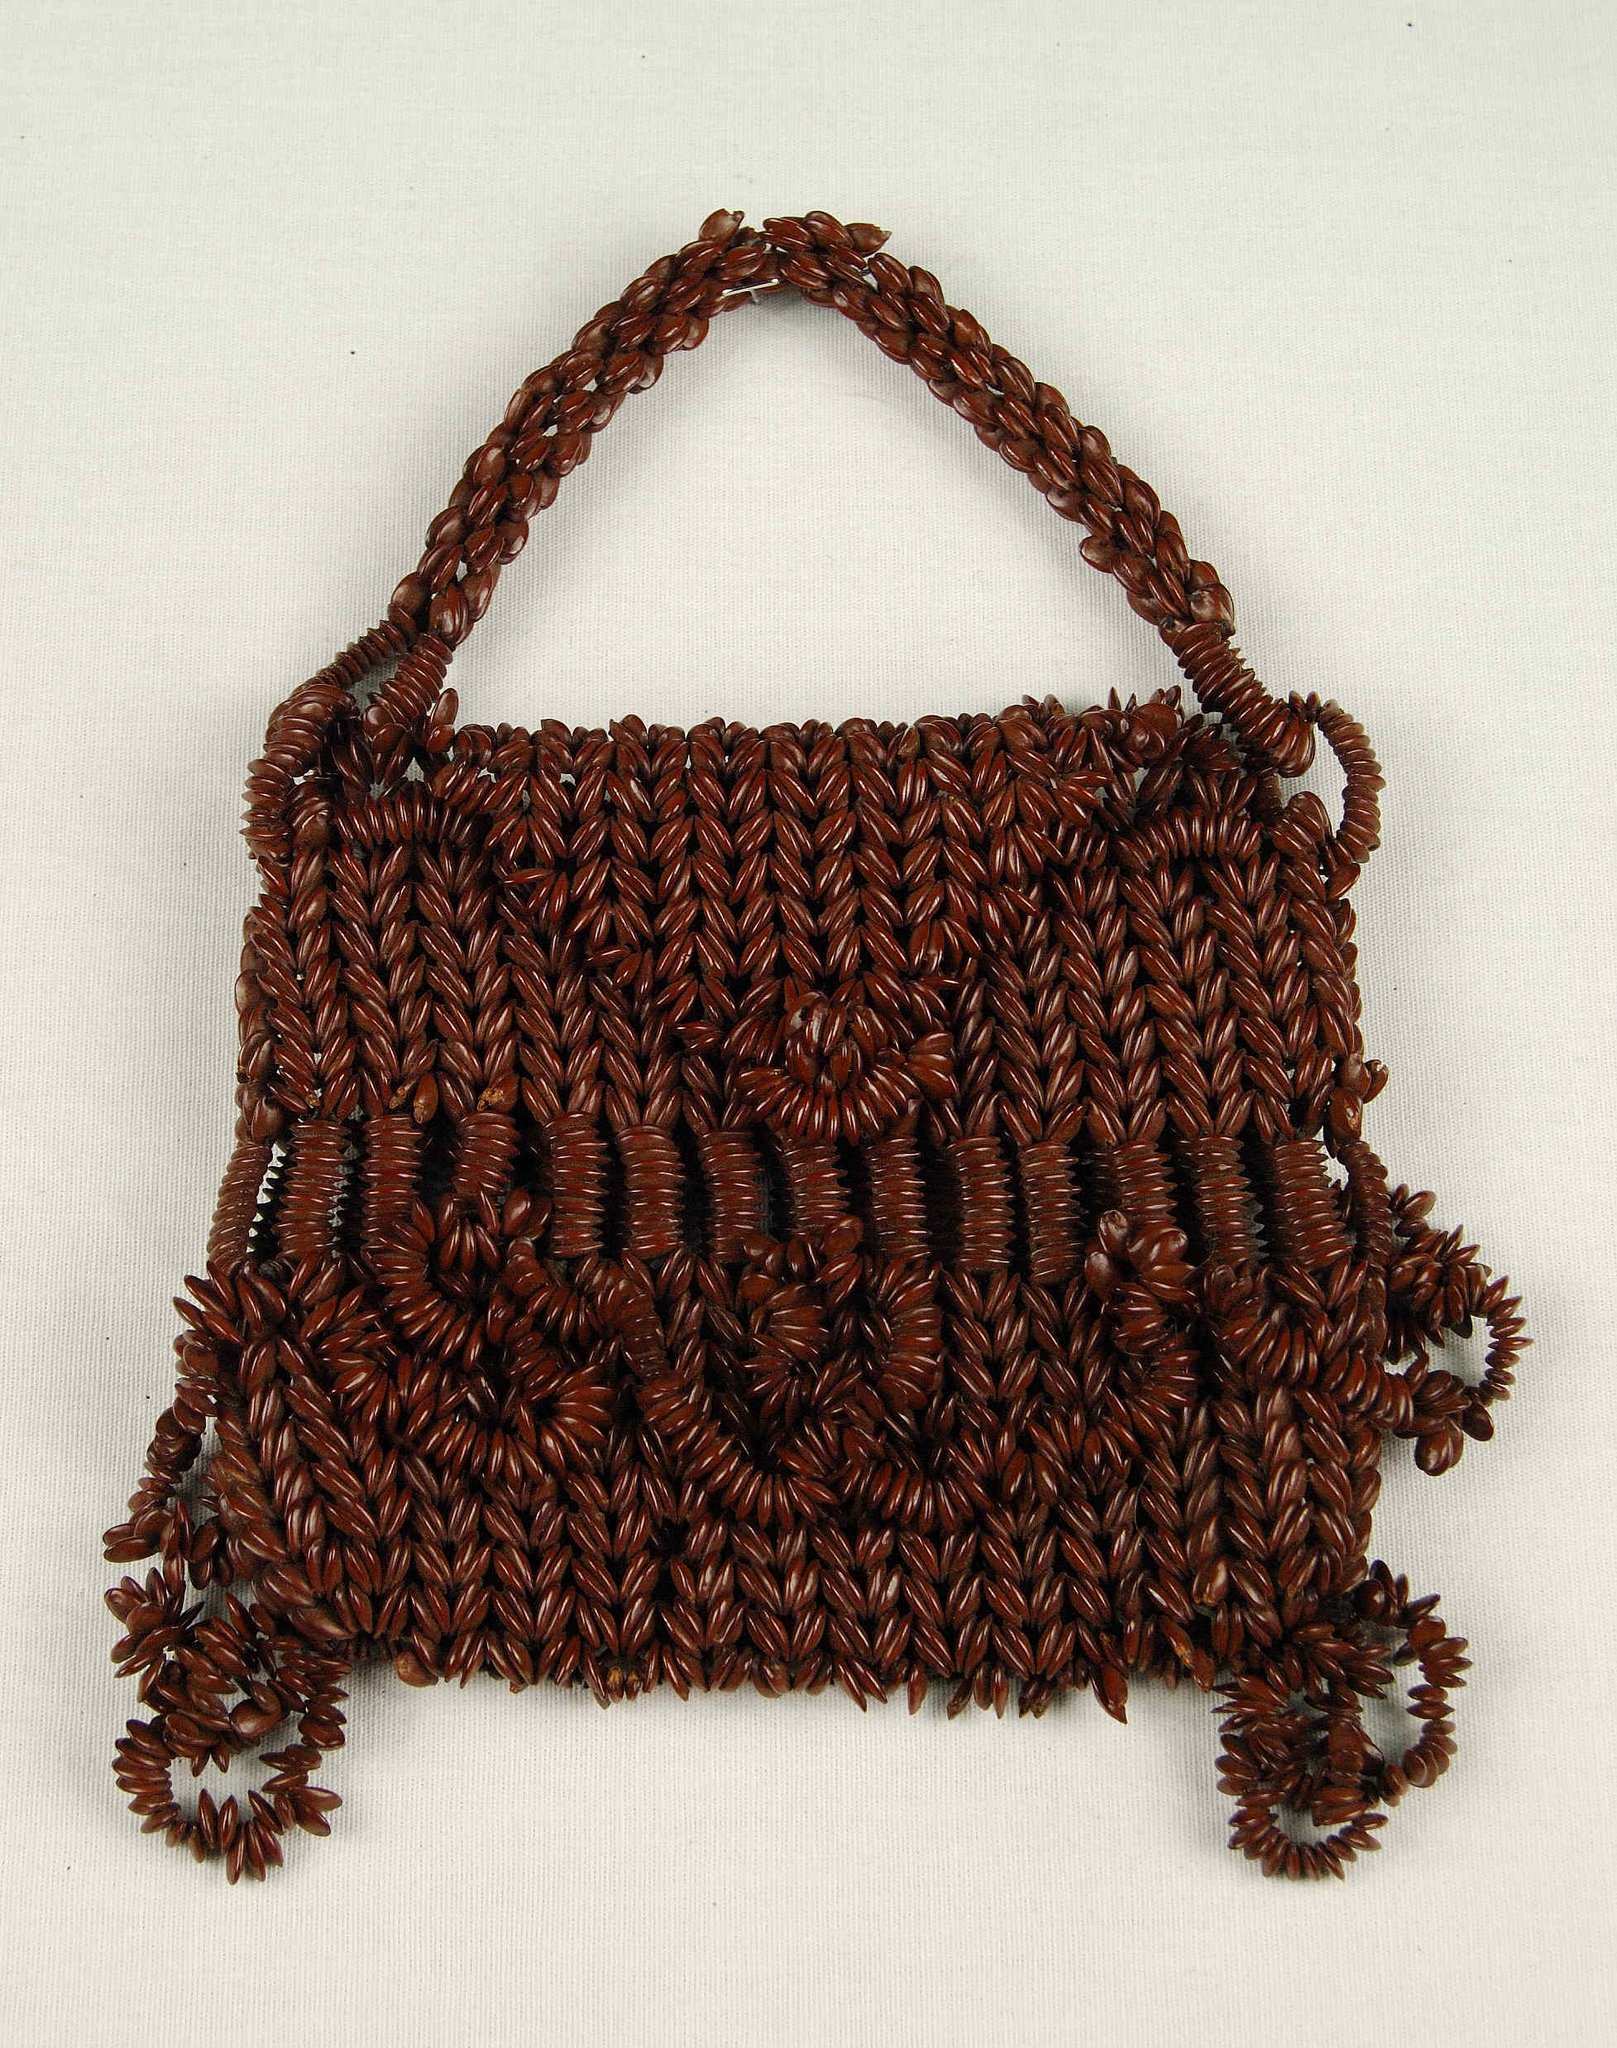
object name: bag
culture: american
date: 1830-1860